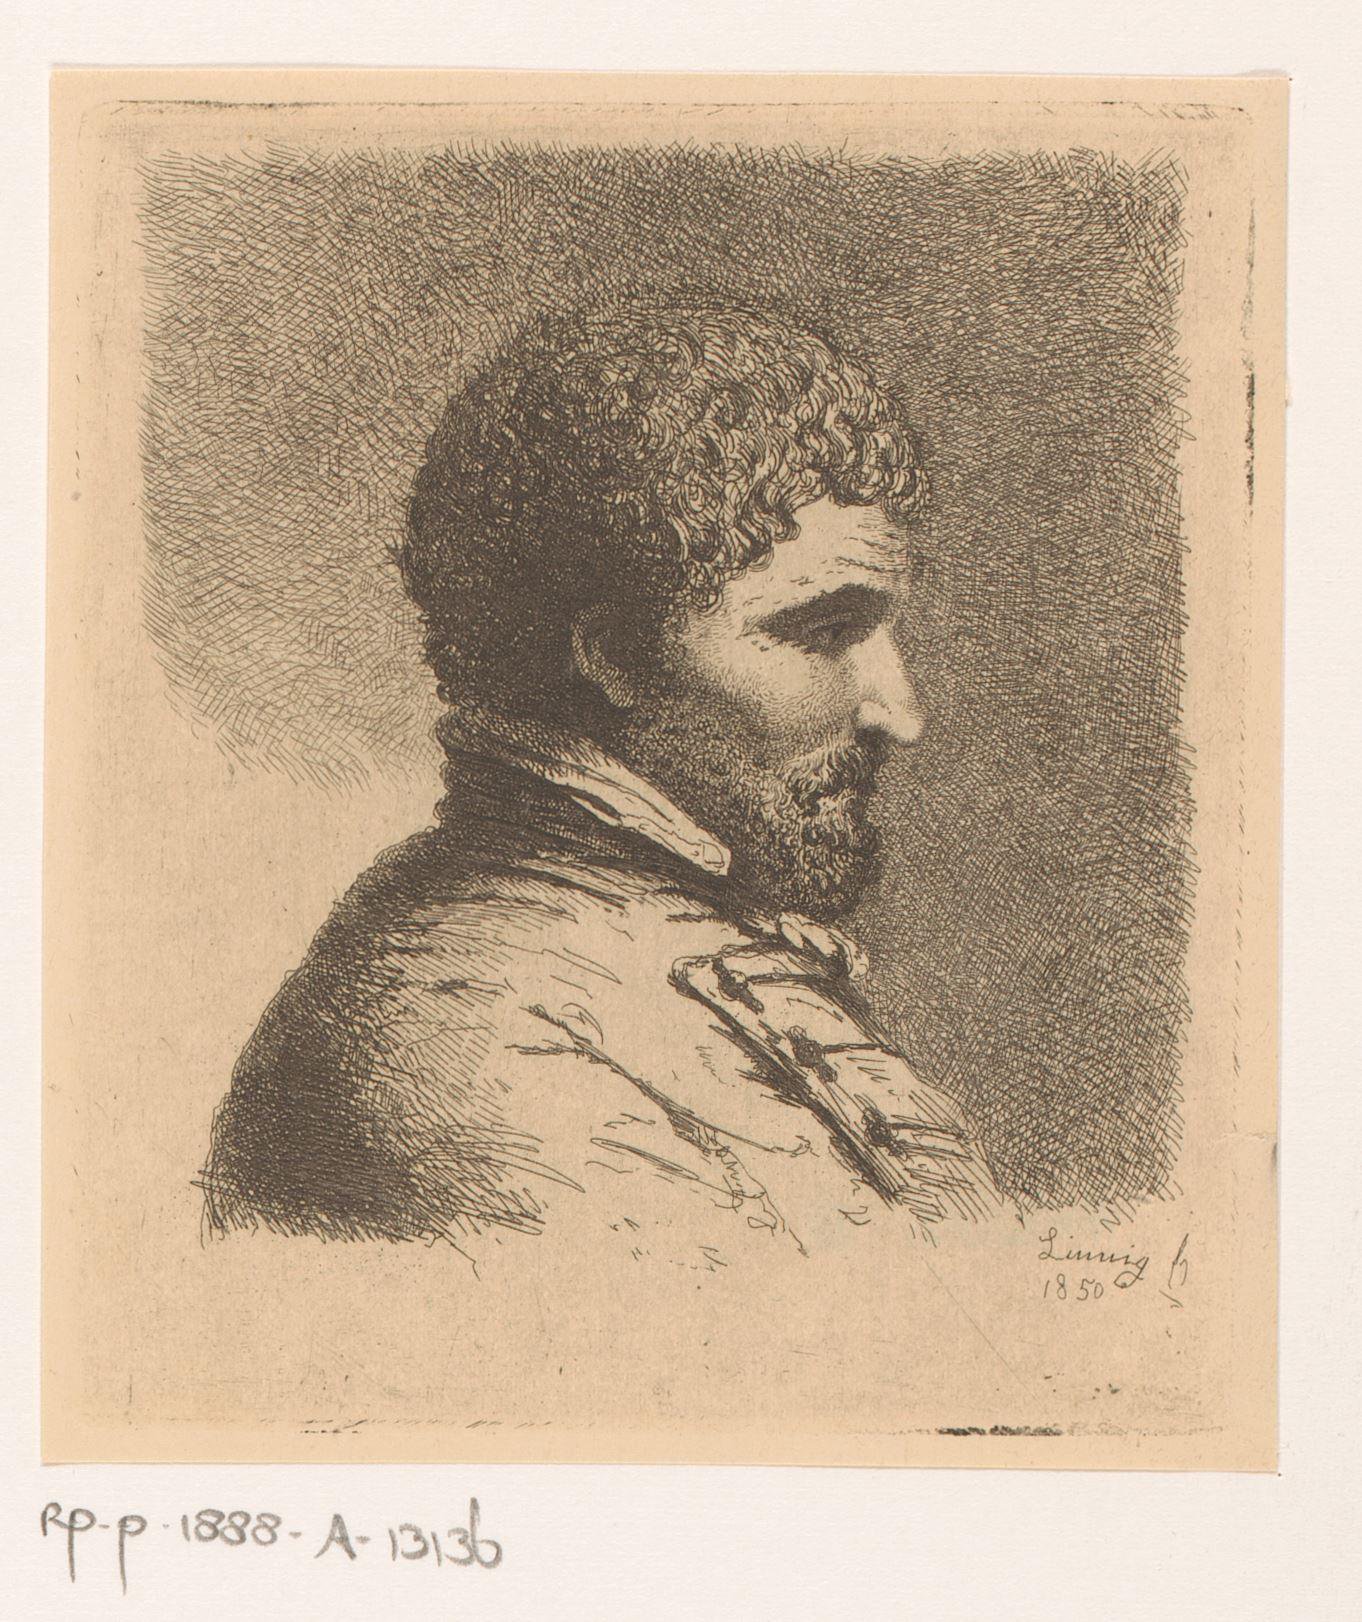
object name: print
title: Portret van een onbekende man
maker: jean théodore joseph linnig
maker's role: draughtsman, print maker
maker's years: 1815-1891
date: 1850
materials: paper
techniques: etching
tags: anonymous historical person portrayed alone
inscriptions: collector's mark: Lugt 2228